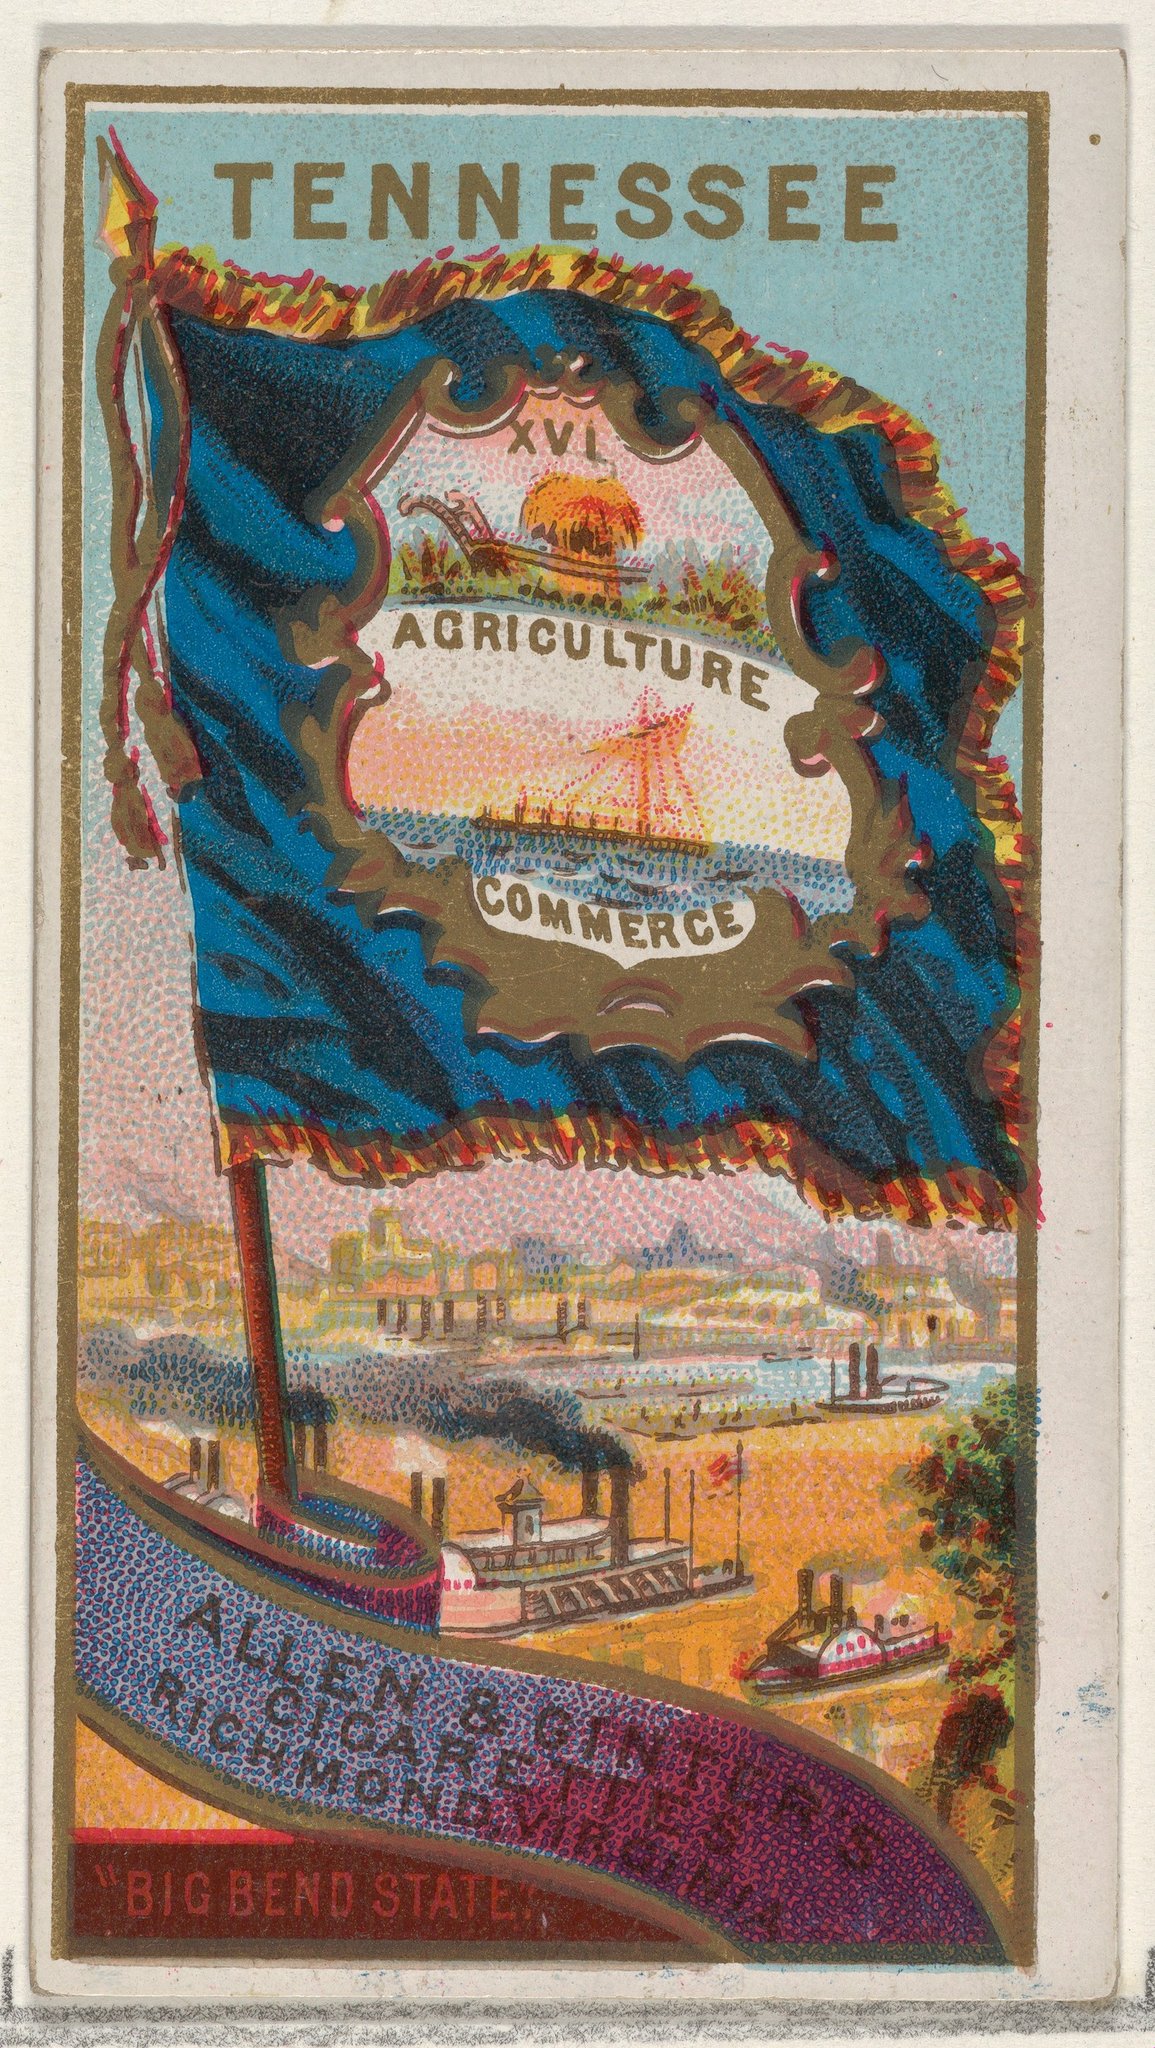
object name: print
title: Tennessee, from Flags of the States and Territories (N11) for Allen & Ginter Cigarettes Brands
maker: allen & ginter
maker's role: publisher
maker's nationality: american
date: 1888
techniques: color lithograph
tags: flags